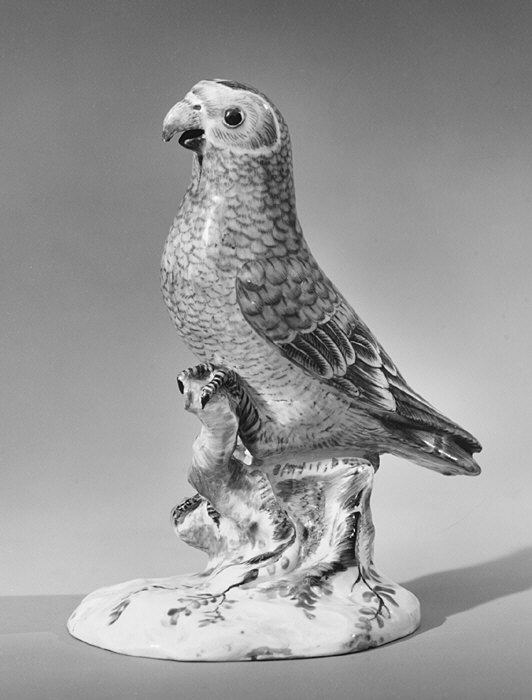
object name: figure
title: Parrot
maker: imperial porcelain manufactory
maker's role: manufactory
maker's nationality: austrian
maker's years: 1744-1864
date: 1753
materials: hard paste porcelain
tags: parrots